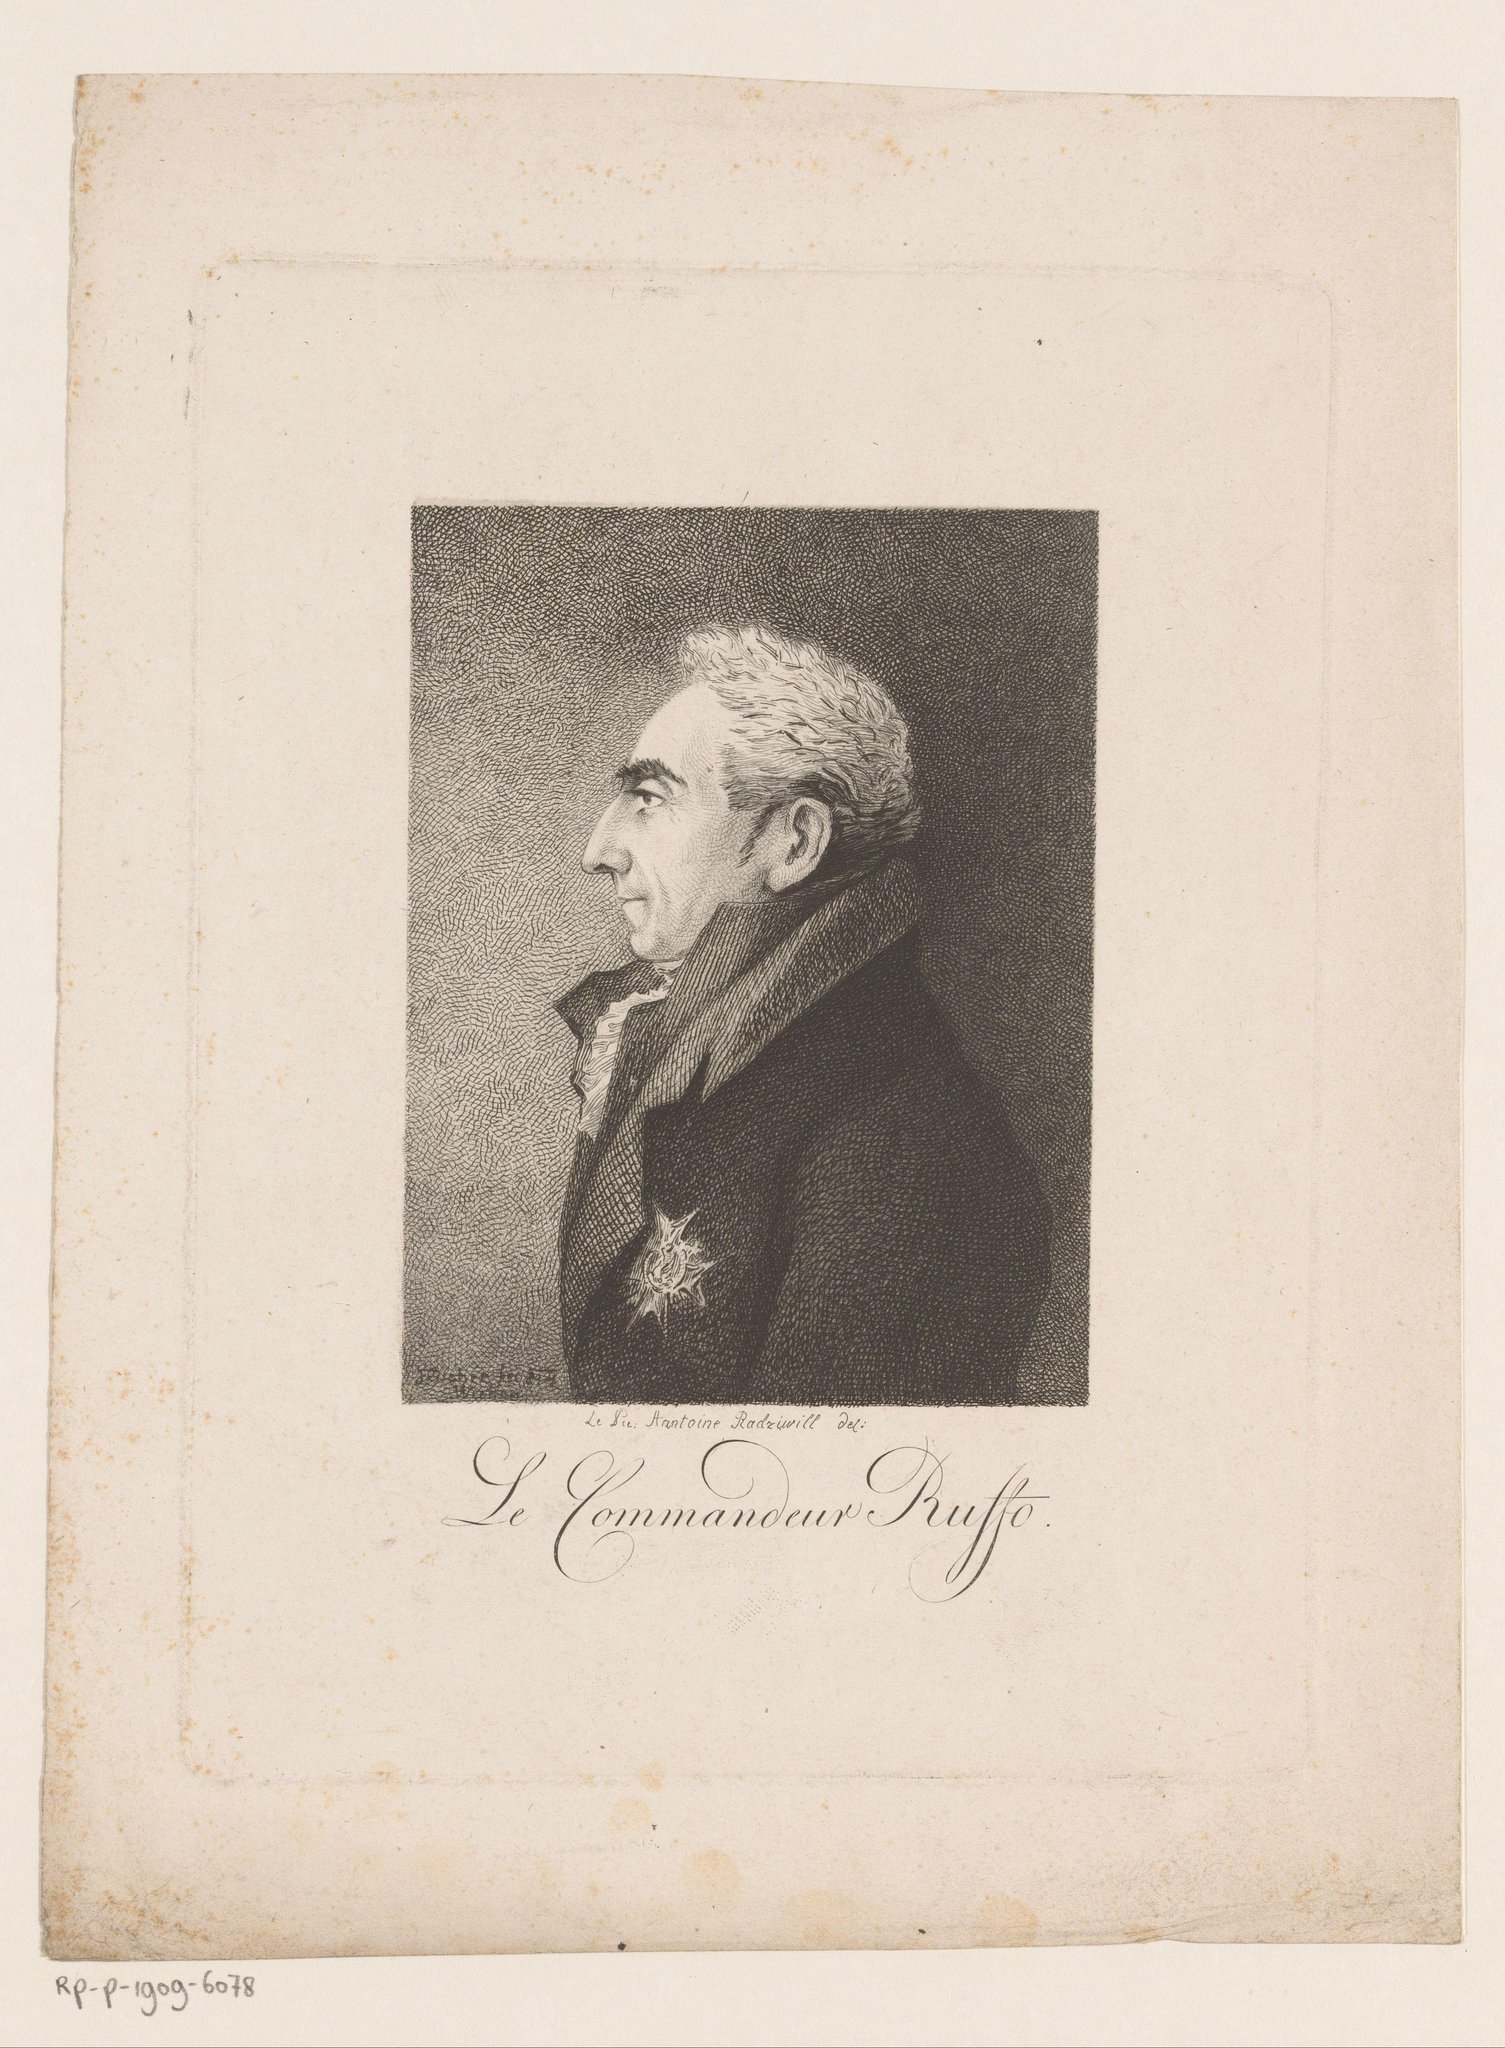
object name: print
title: Portret van een onbekende man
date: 1785-1822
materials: paper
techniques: etching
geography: vienna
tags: knighthood order, historical persons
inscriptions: collector's mark: Lugt 2228